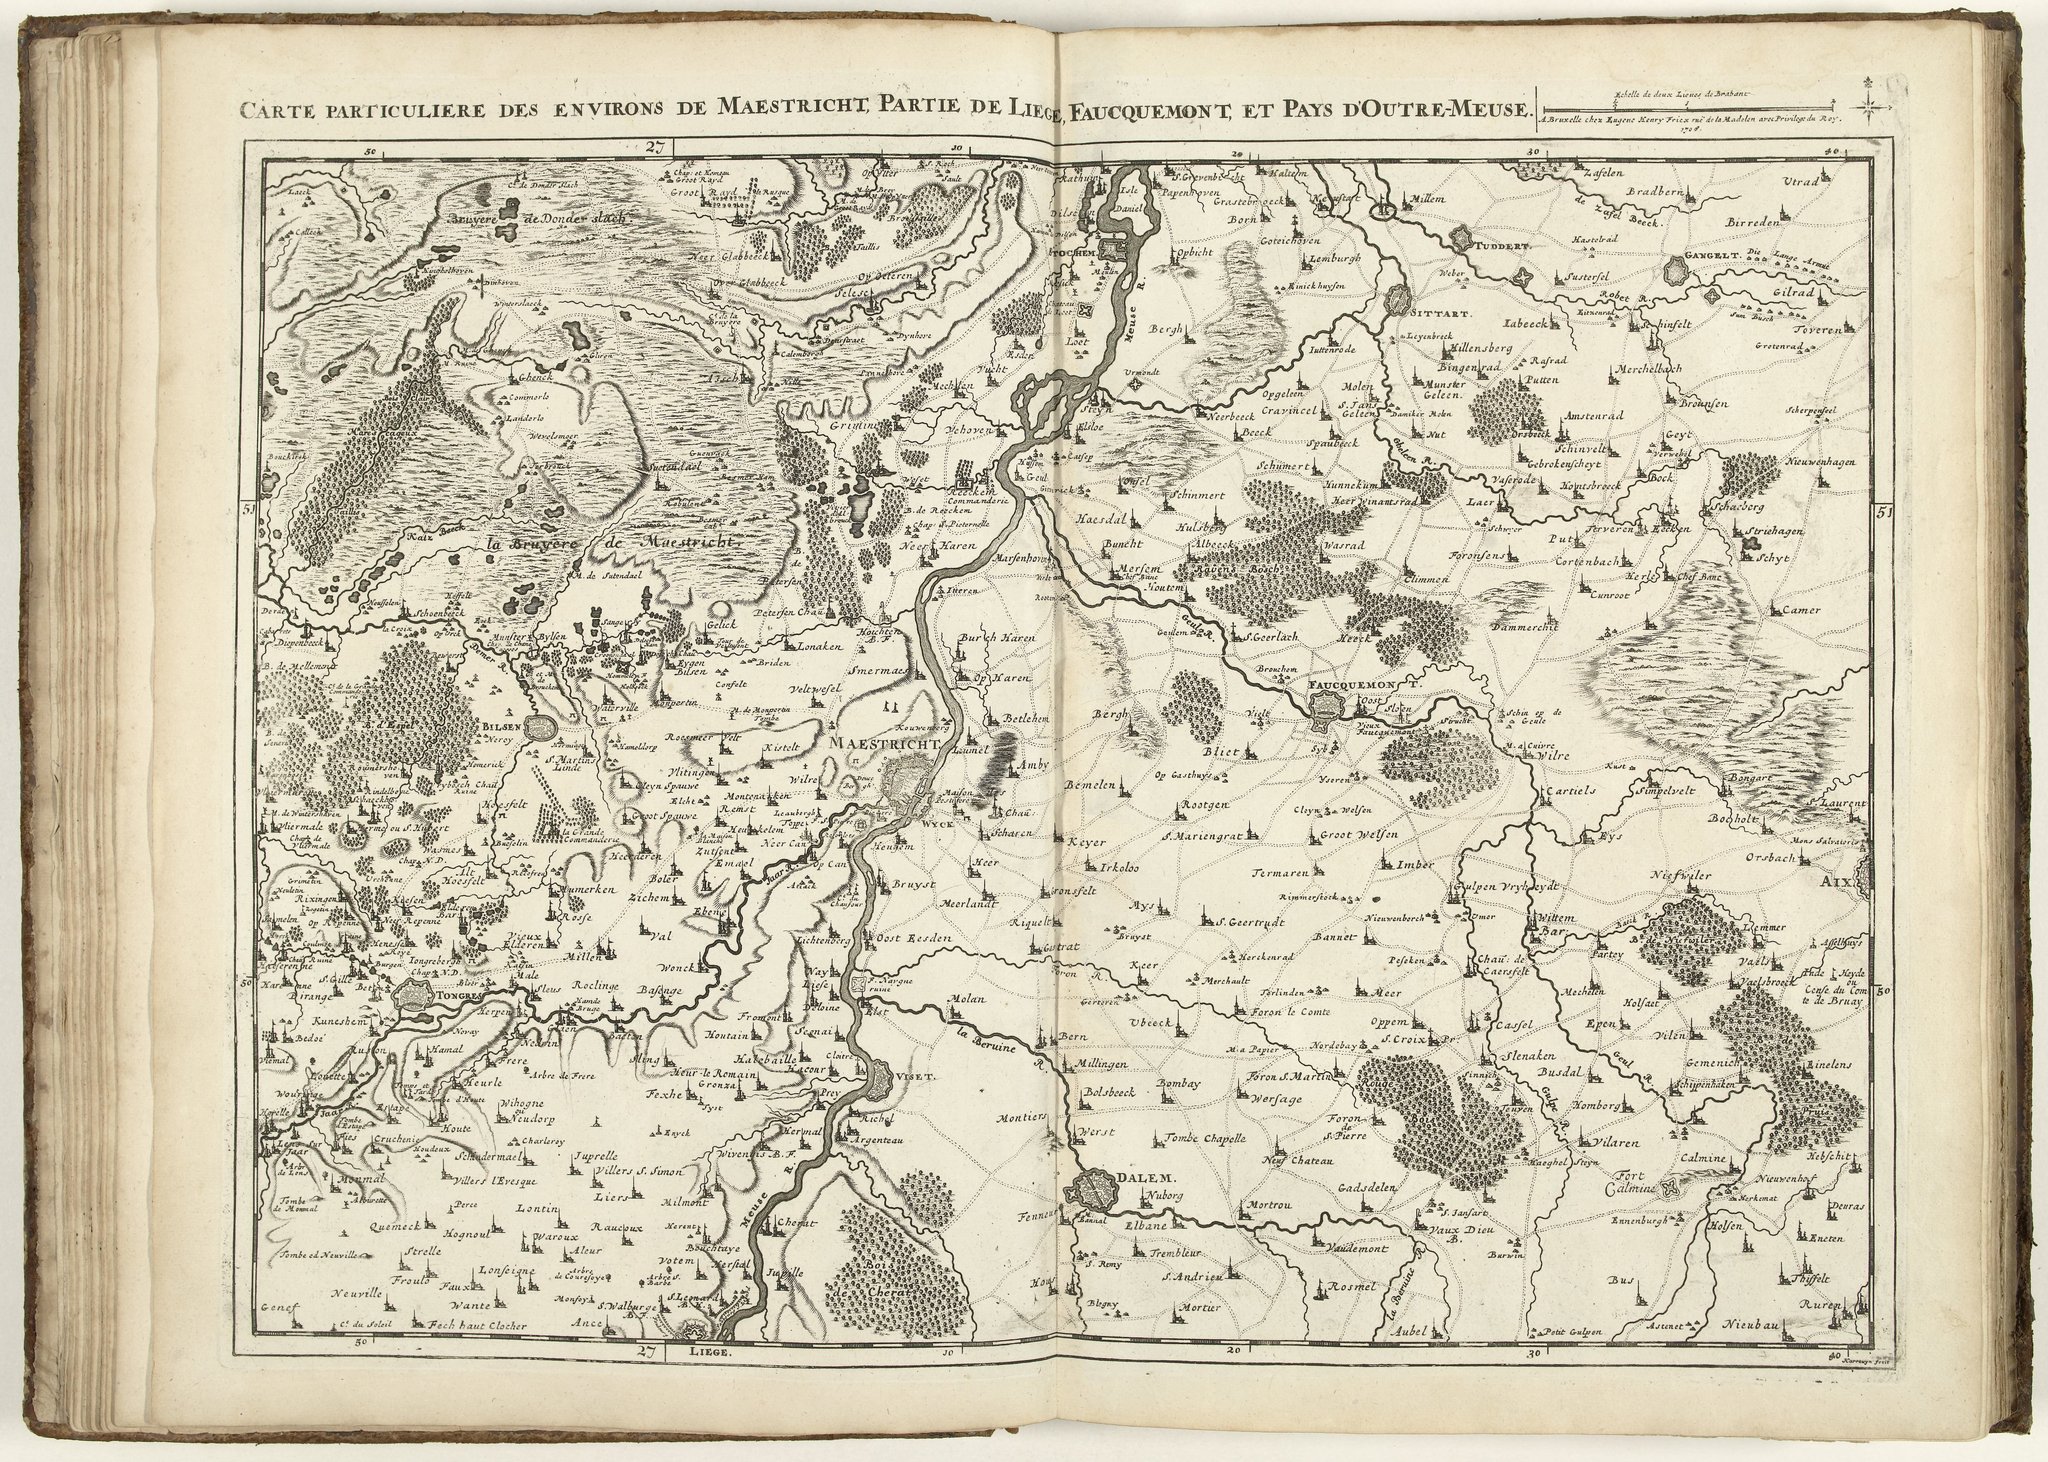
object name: print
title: Kaart van Limburg met de omgeving rond Maastricht, 1708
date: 1708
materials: paper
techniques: engraving, etching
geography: brussels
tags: maps of separate countries or regions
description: Kaart van Limburg met de omgeving rond Maastricht, een deel van Luik en Valkenburg, 1708. Rechtsboven een schaalstok: Echelle de deux Lieues de Brabant. De kaart is voorzien van een gradenverdeling langs de randen. Onderdeel van een gebundelde verzameling van plannen van veldslagen en steden vermaard in de Spaanse Successieoorlog. Deze plaat behoort tot de eerste 24 platen die samen een zeer grote kaart van de Zuidelijke Nederlanden vormen.